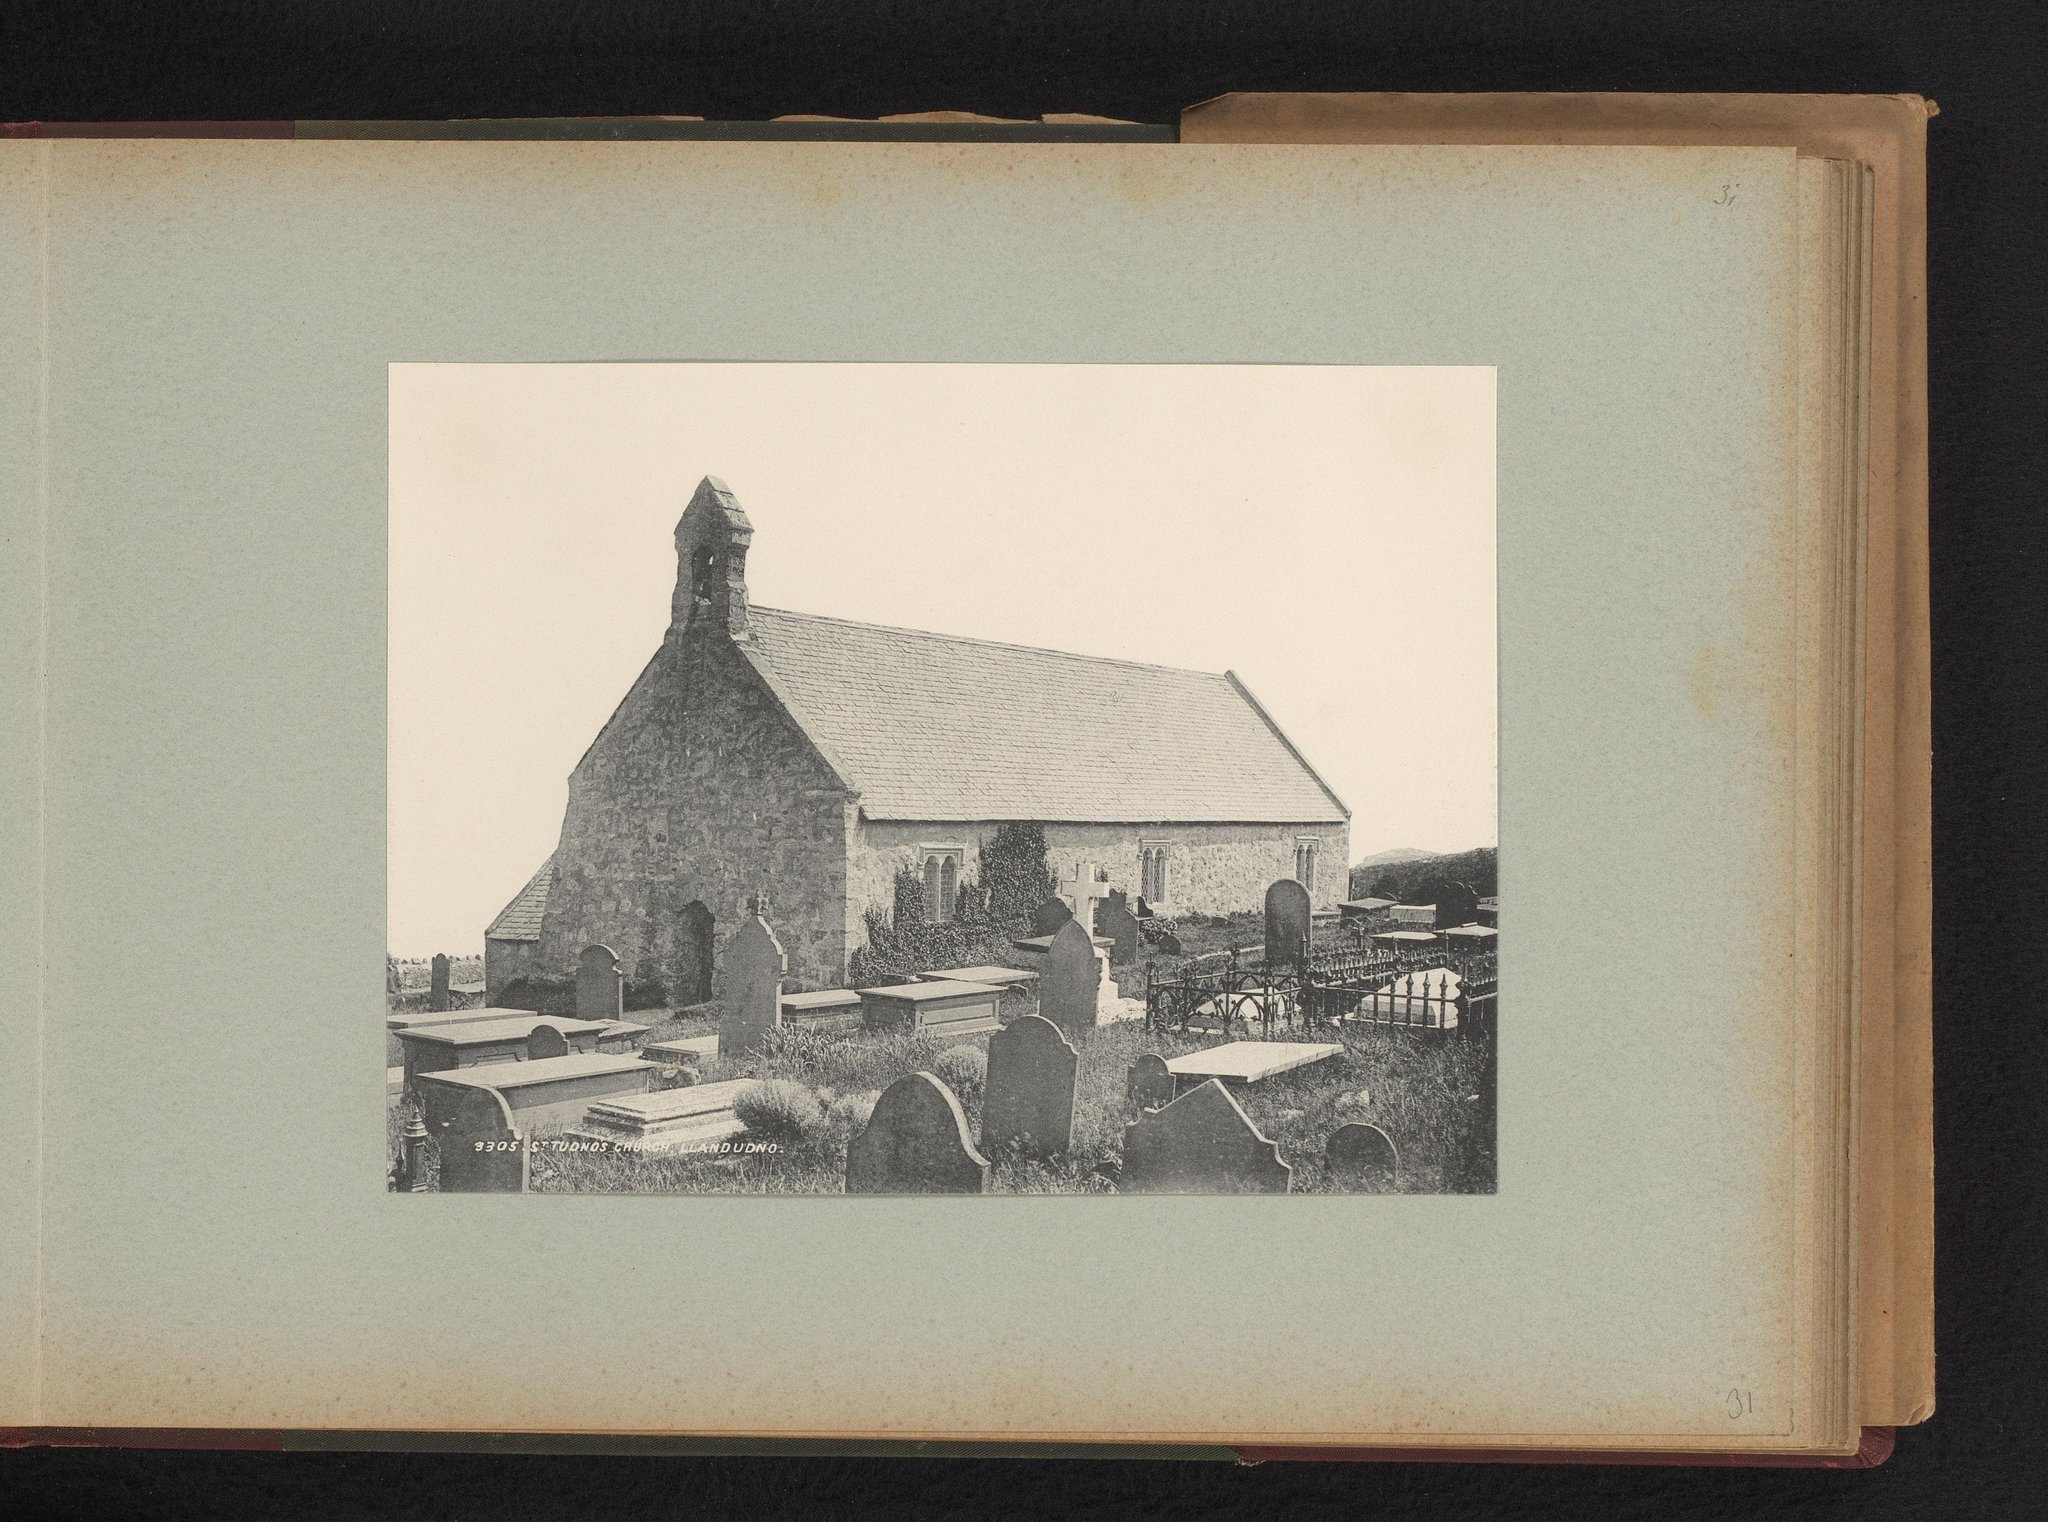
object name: photomechanical print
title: Begraafplaats van St. Tudno's Church te Llandudno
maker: Anonymous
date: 1880-1900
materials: paper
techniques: photograph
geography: llandudno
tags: churchyard (around church)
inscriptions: number: ‘3305.’, number: ‘31’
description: Deze prent maakt deel uit van een album.